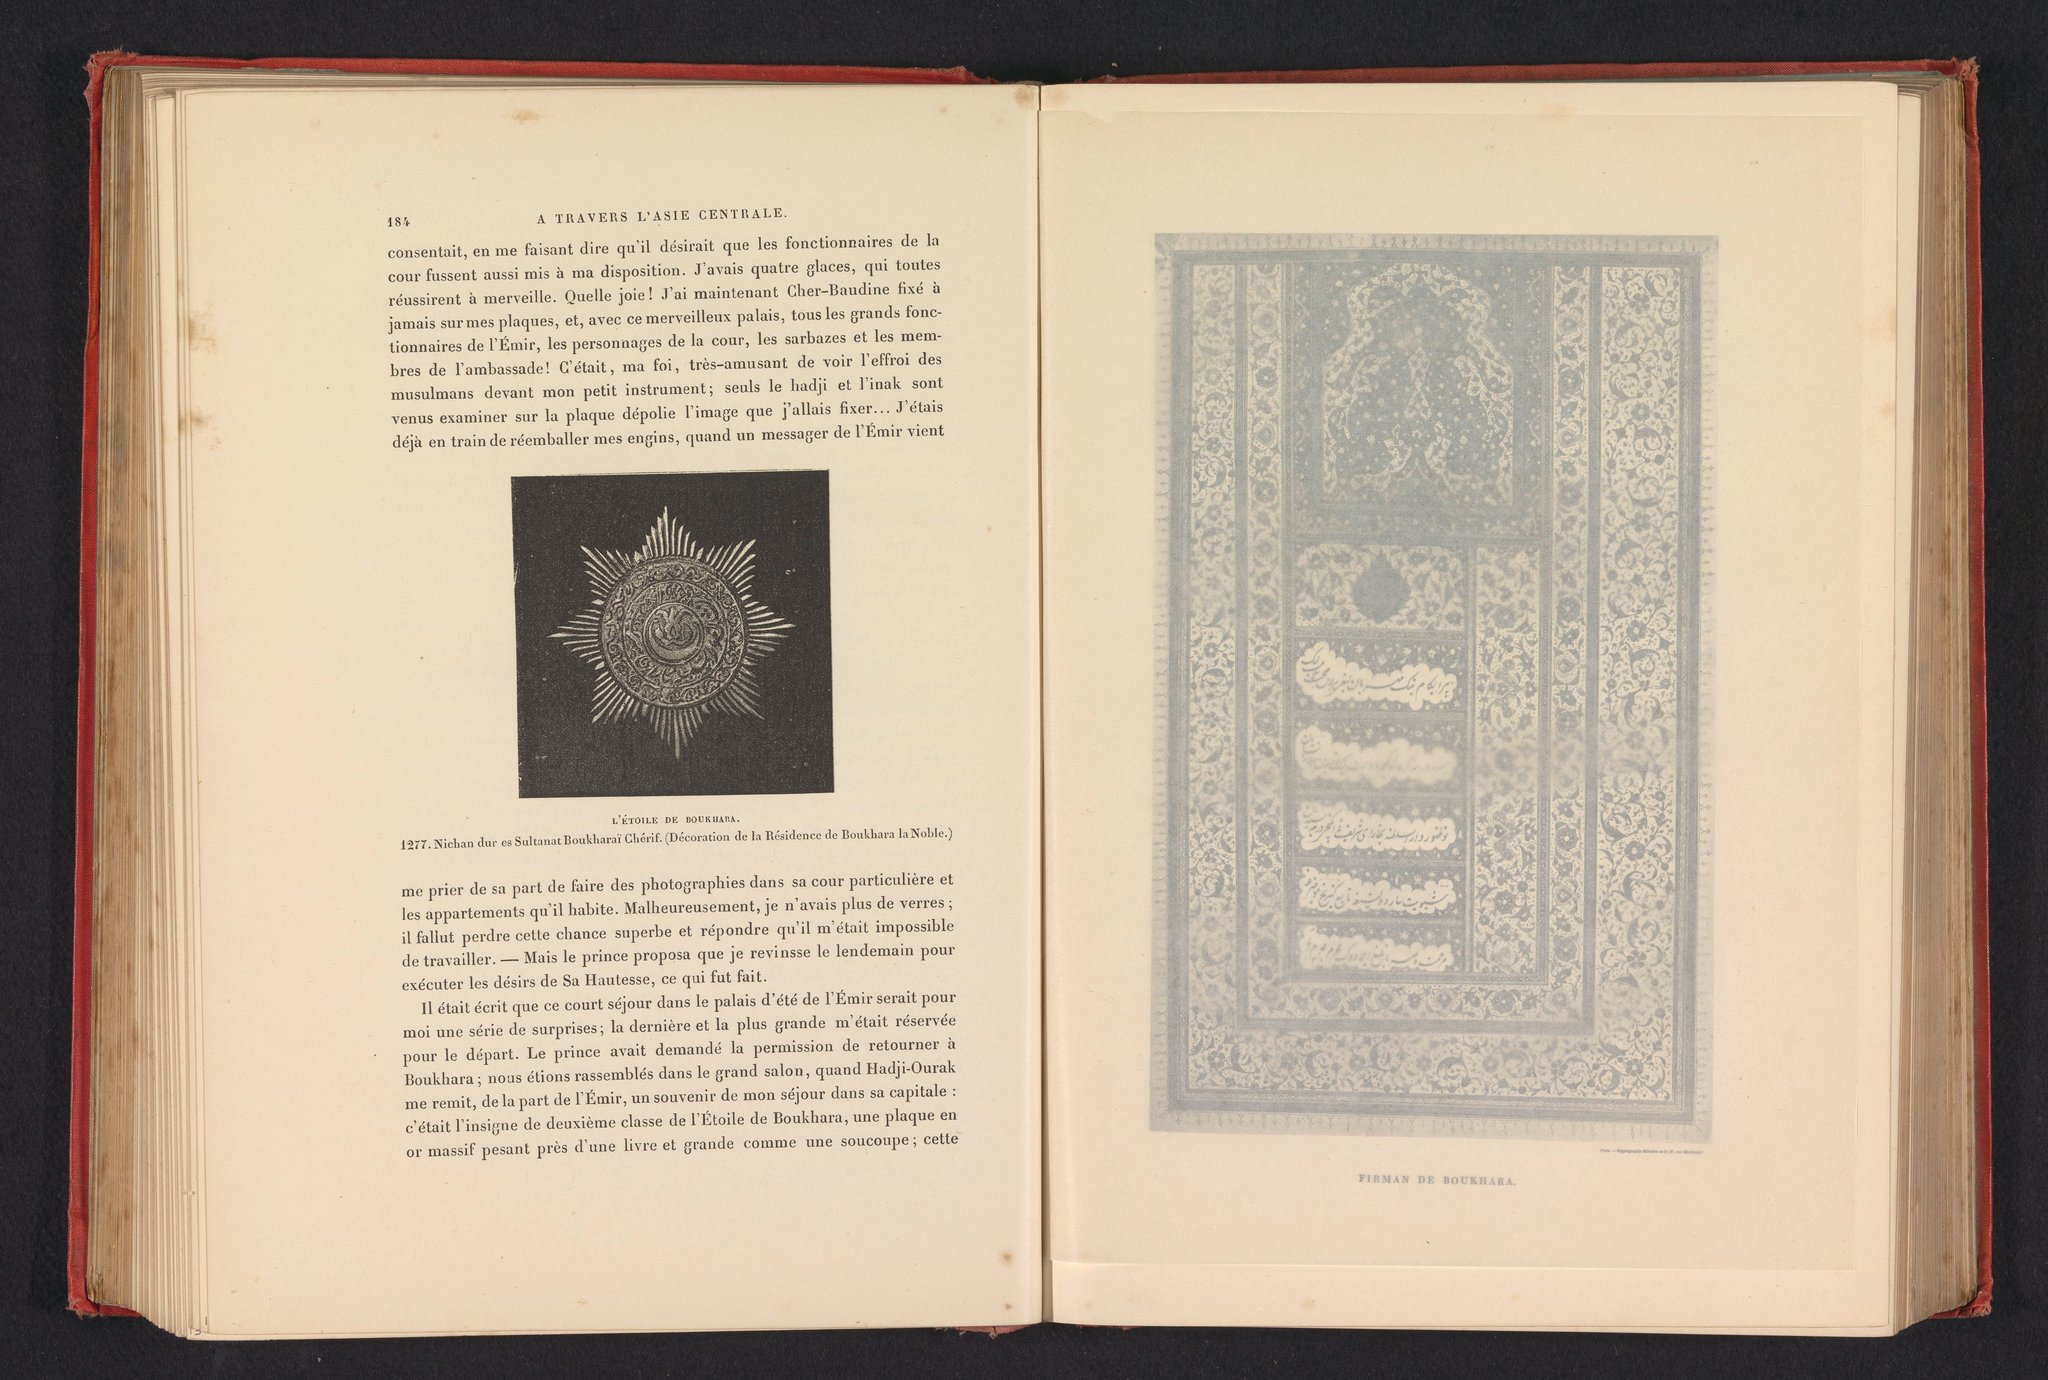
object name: photomechanical print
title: Decoratie in de vorm van een ster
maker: Anonymous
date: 1869-1885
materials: paper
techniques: autotype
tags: ornamenting, decorating ~ applied arts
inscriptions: inscription: ‘1277. Nichan dur es Sultanat Boukharaï Chérif. (Décoration de la Résidence de Boukhara la Noble.)’